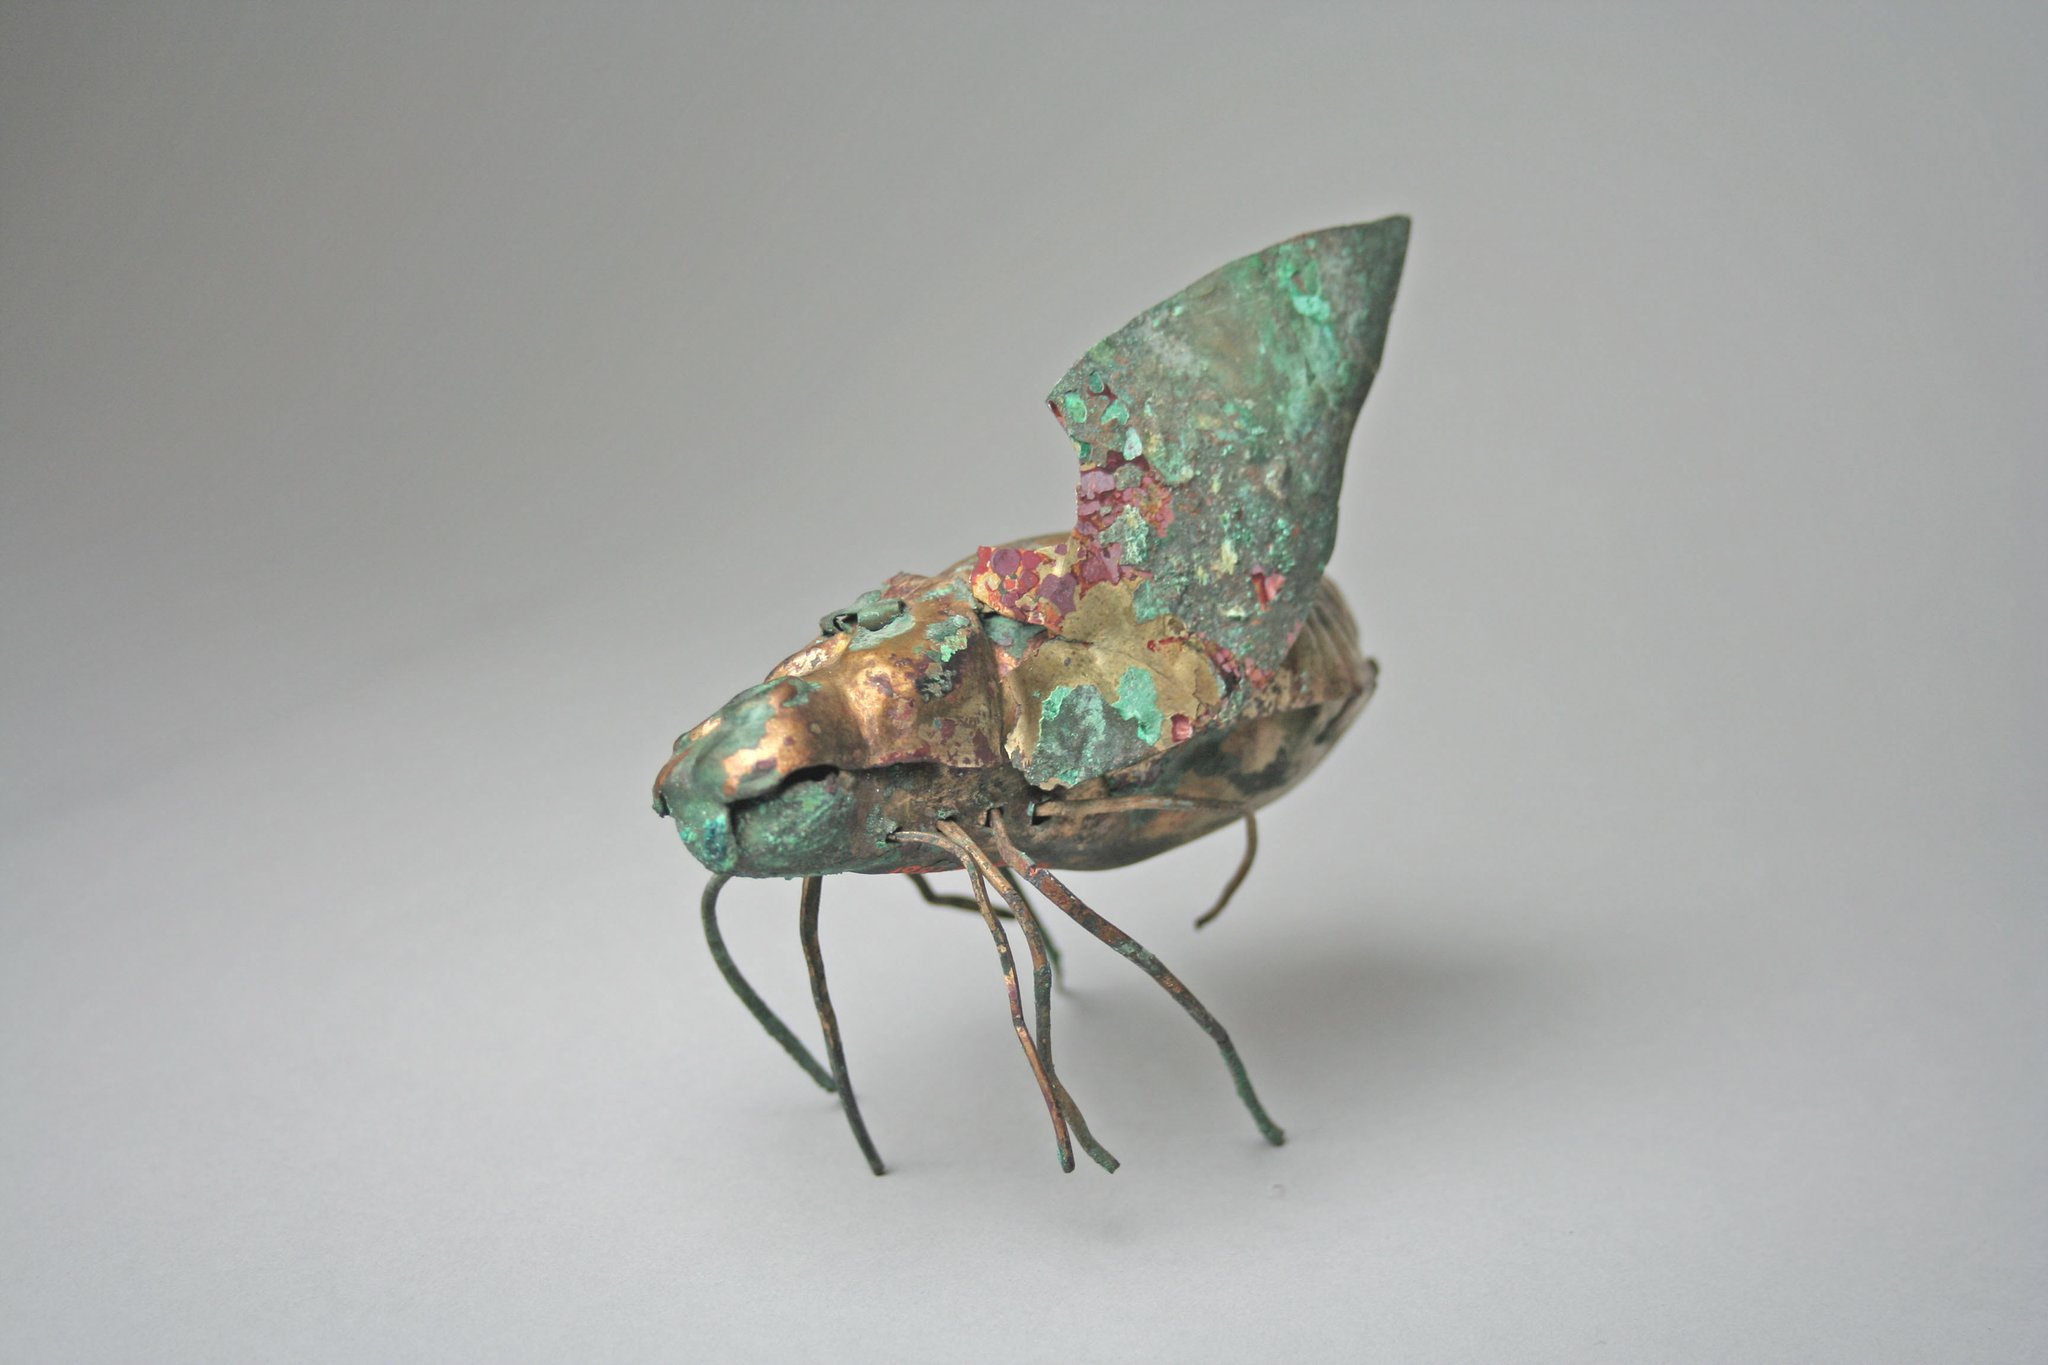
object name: ornament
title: Bee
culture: moche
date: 501-700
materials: gilt copper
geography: peru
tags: bees